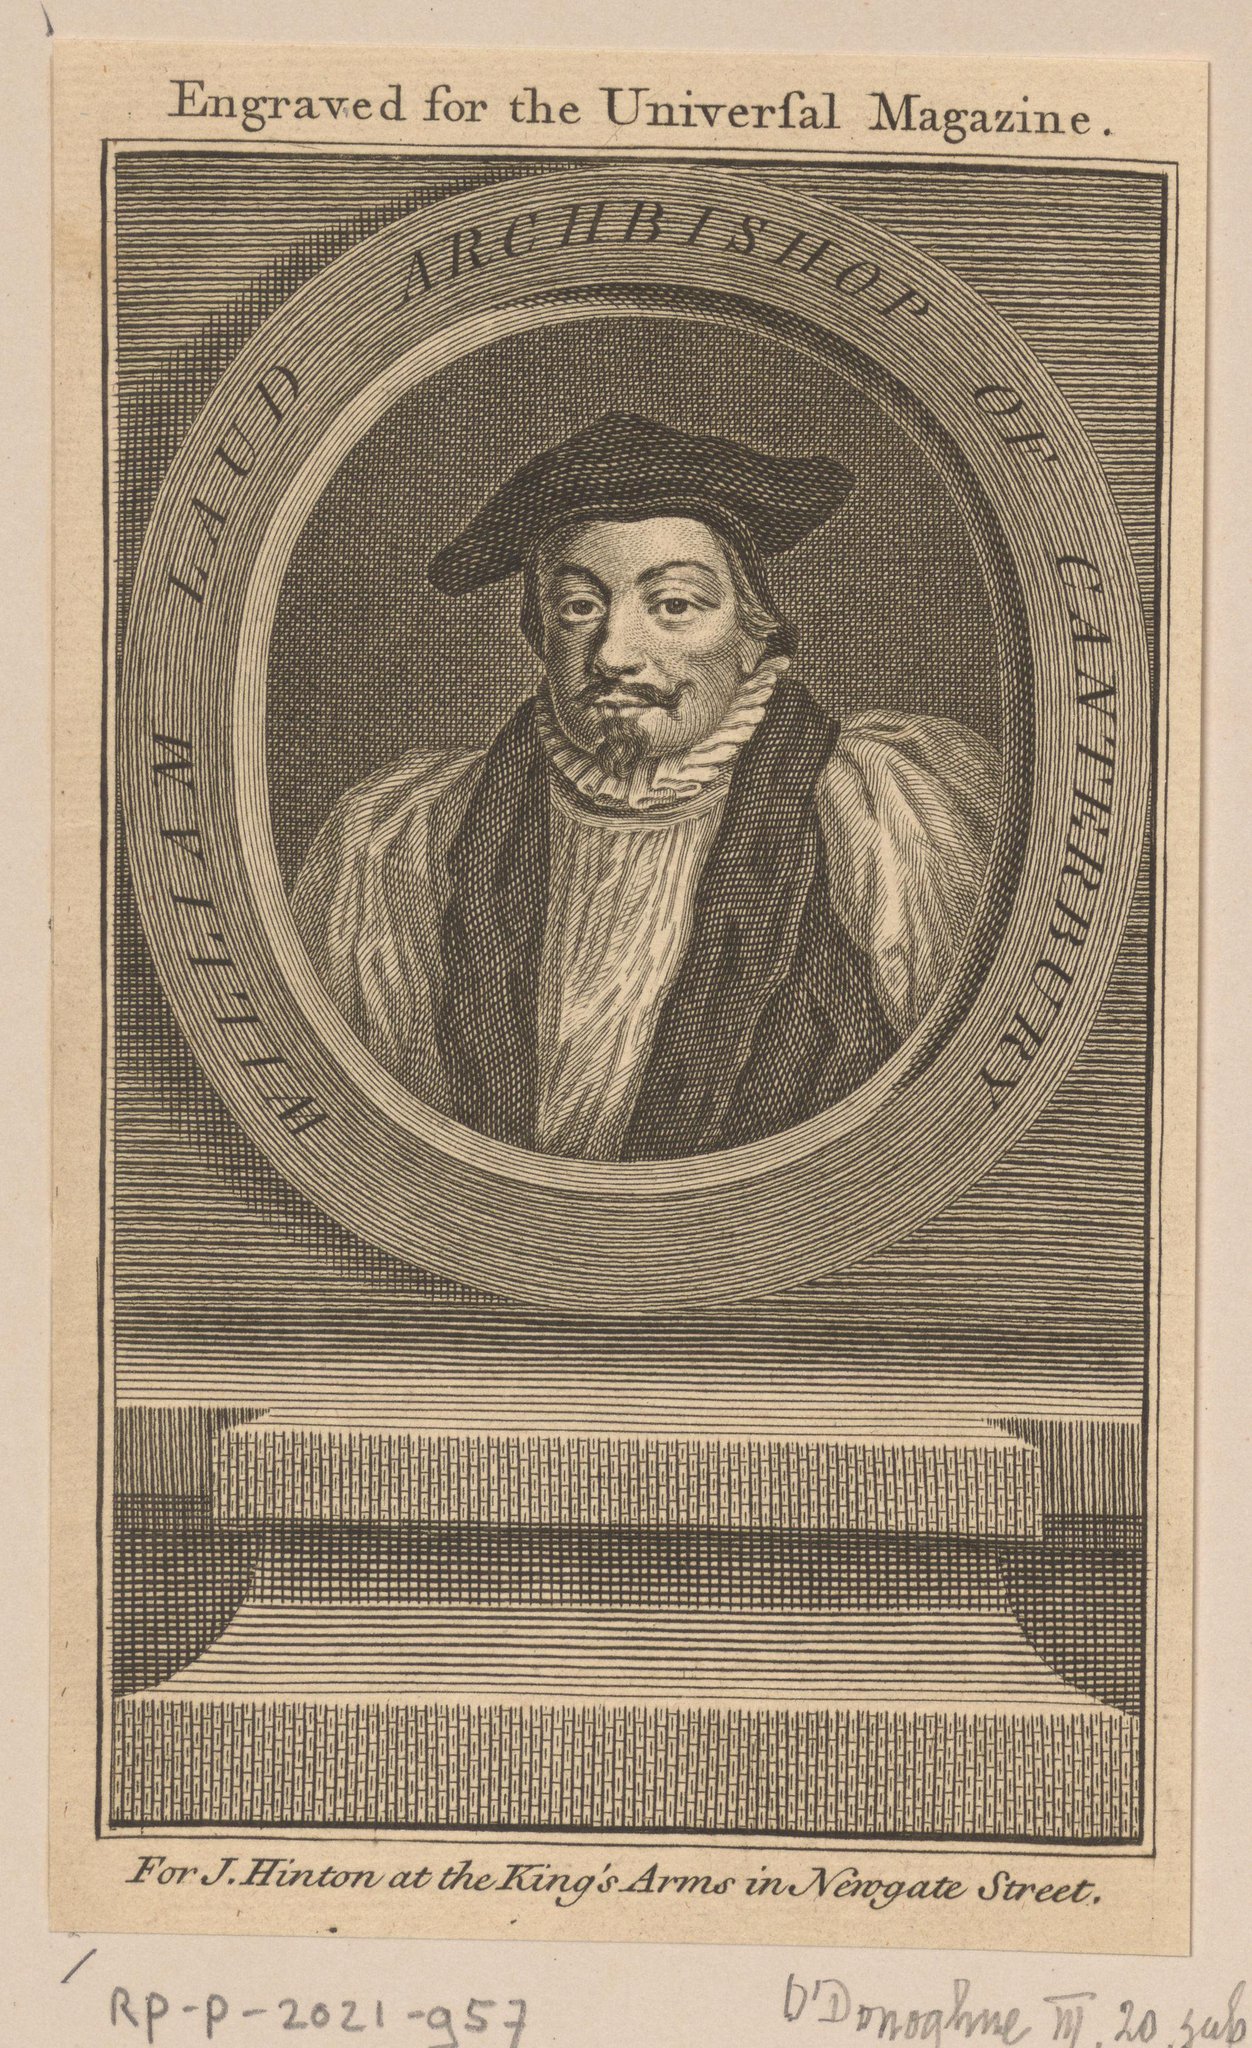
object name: print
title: Portret van William Laud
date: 1747-1781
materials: paper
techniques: etching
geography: england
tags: london, clergyman, archbishop, bishop, etc. (roman catholic), ornament ~ medallion, historical persons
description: Prent komt uit een editie van The Universal Magazine.